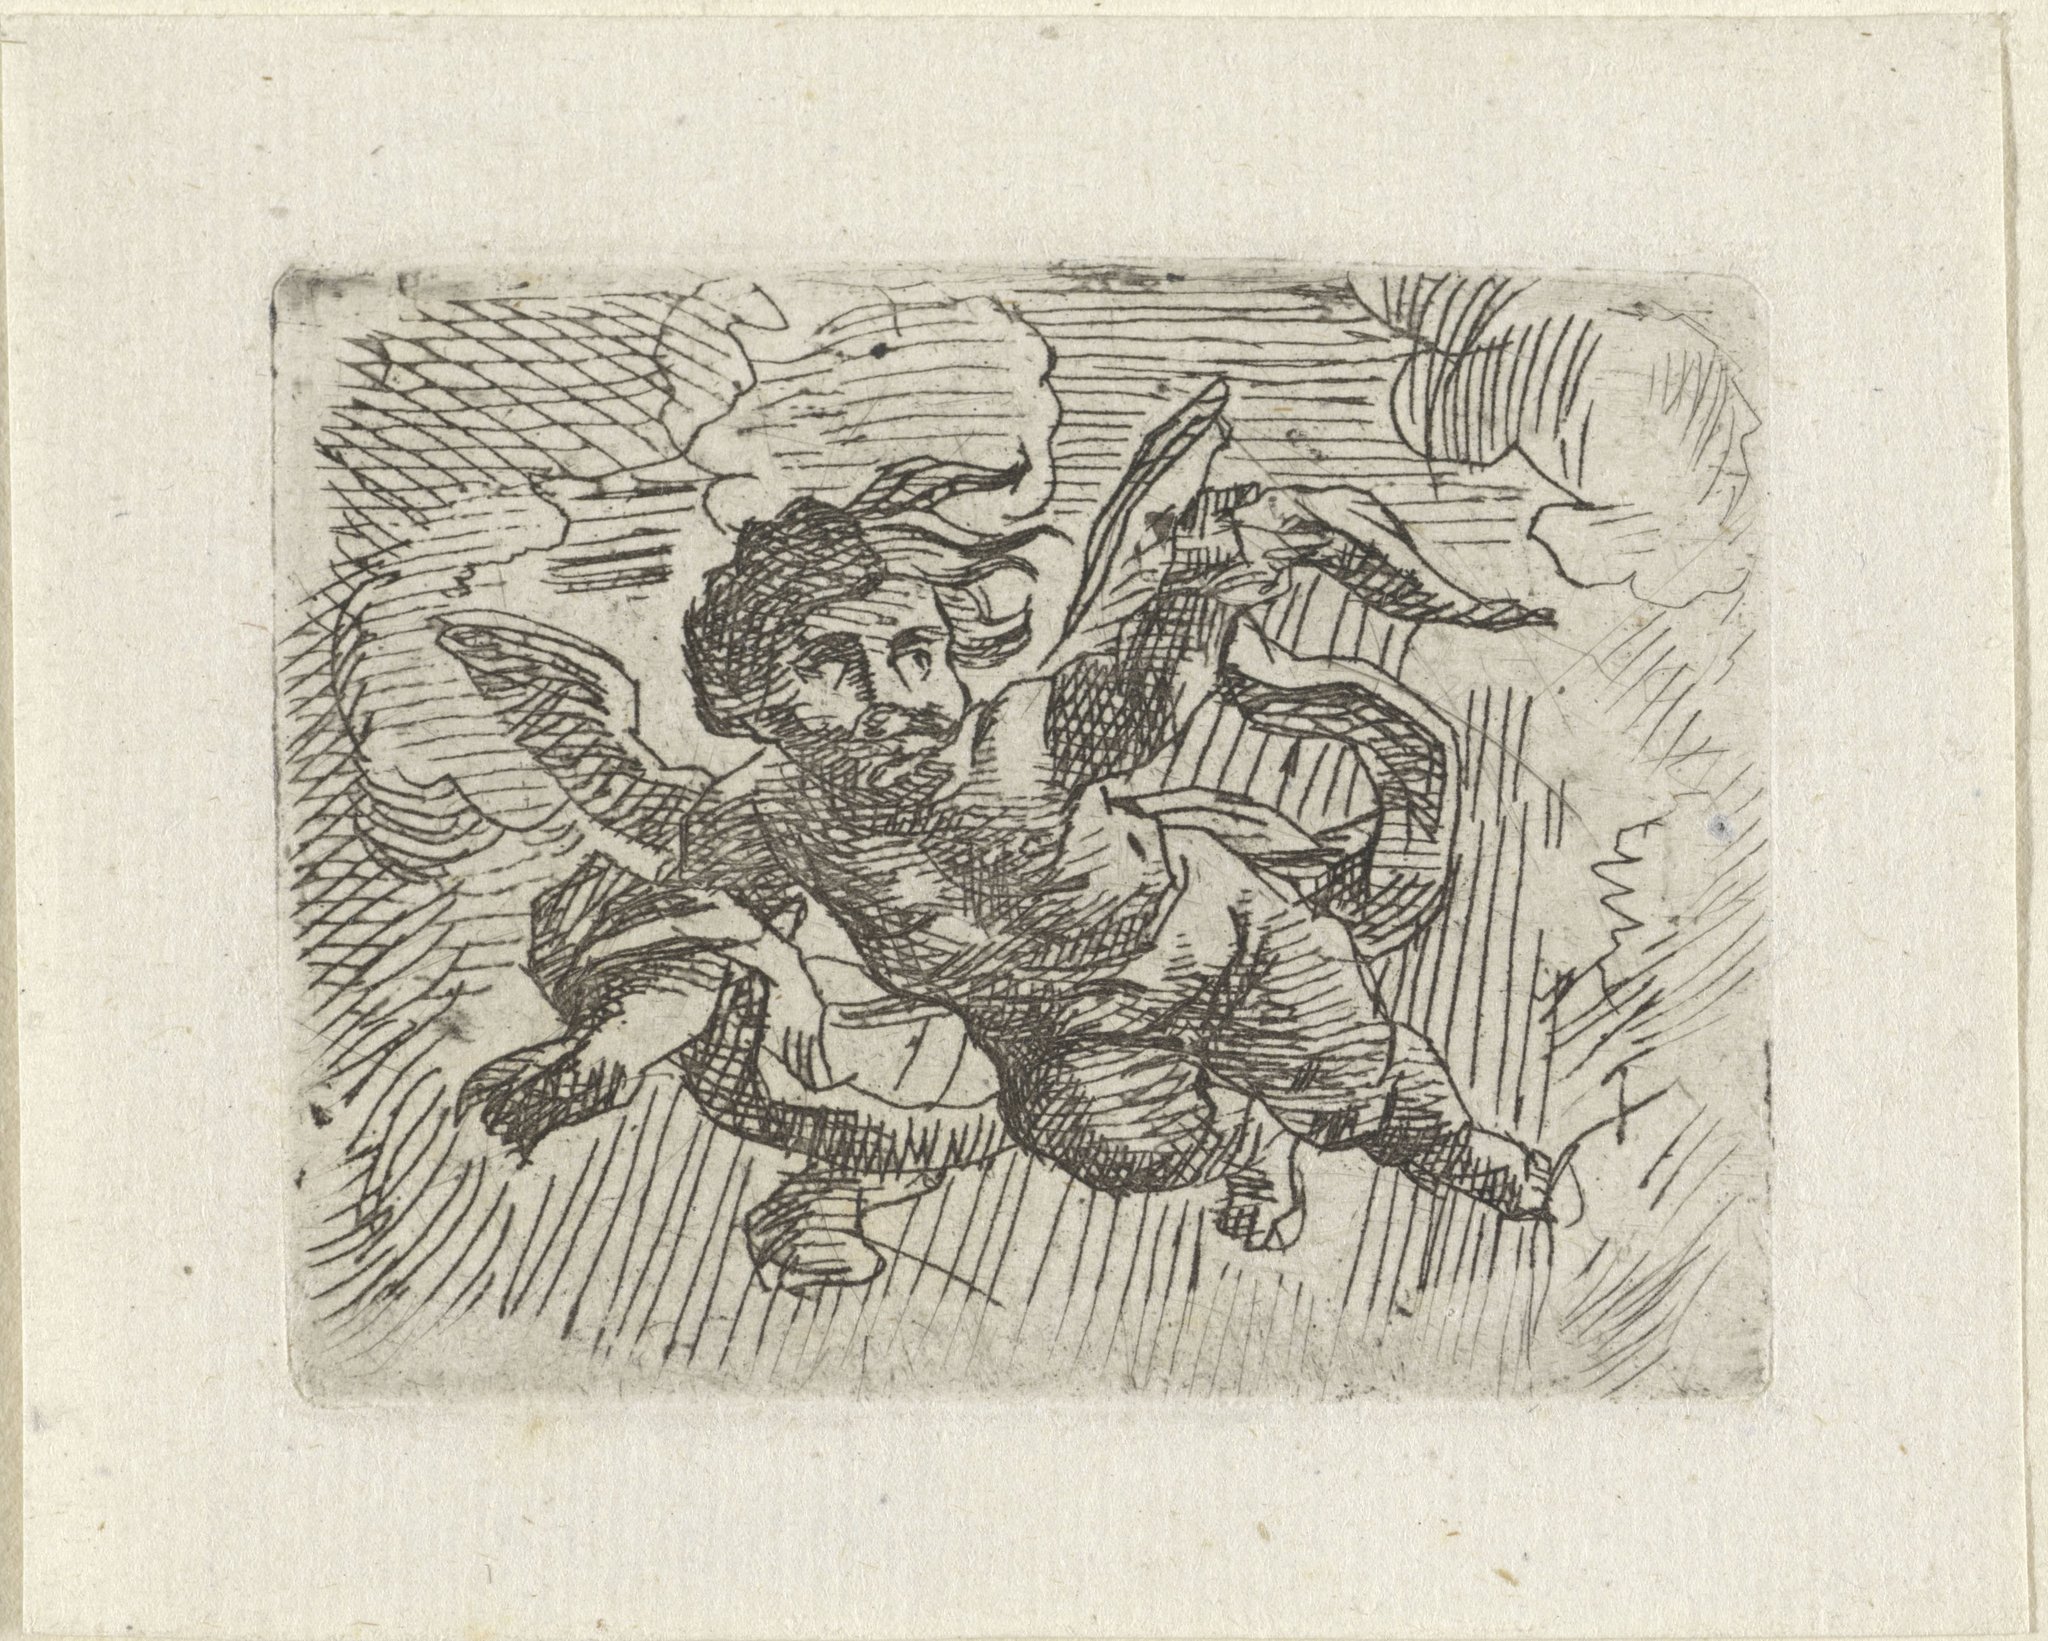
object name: print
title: Vliegende putto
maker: cornelis schut (i)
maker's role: draughtsman, print maker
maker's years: 1597-1655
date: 1618-1655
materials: paper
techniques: etching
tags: flying, cupids: 'amores', 'amoretti', 'putti'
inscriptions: collector's mark: Lugt 2228